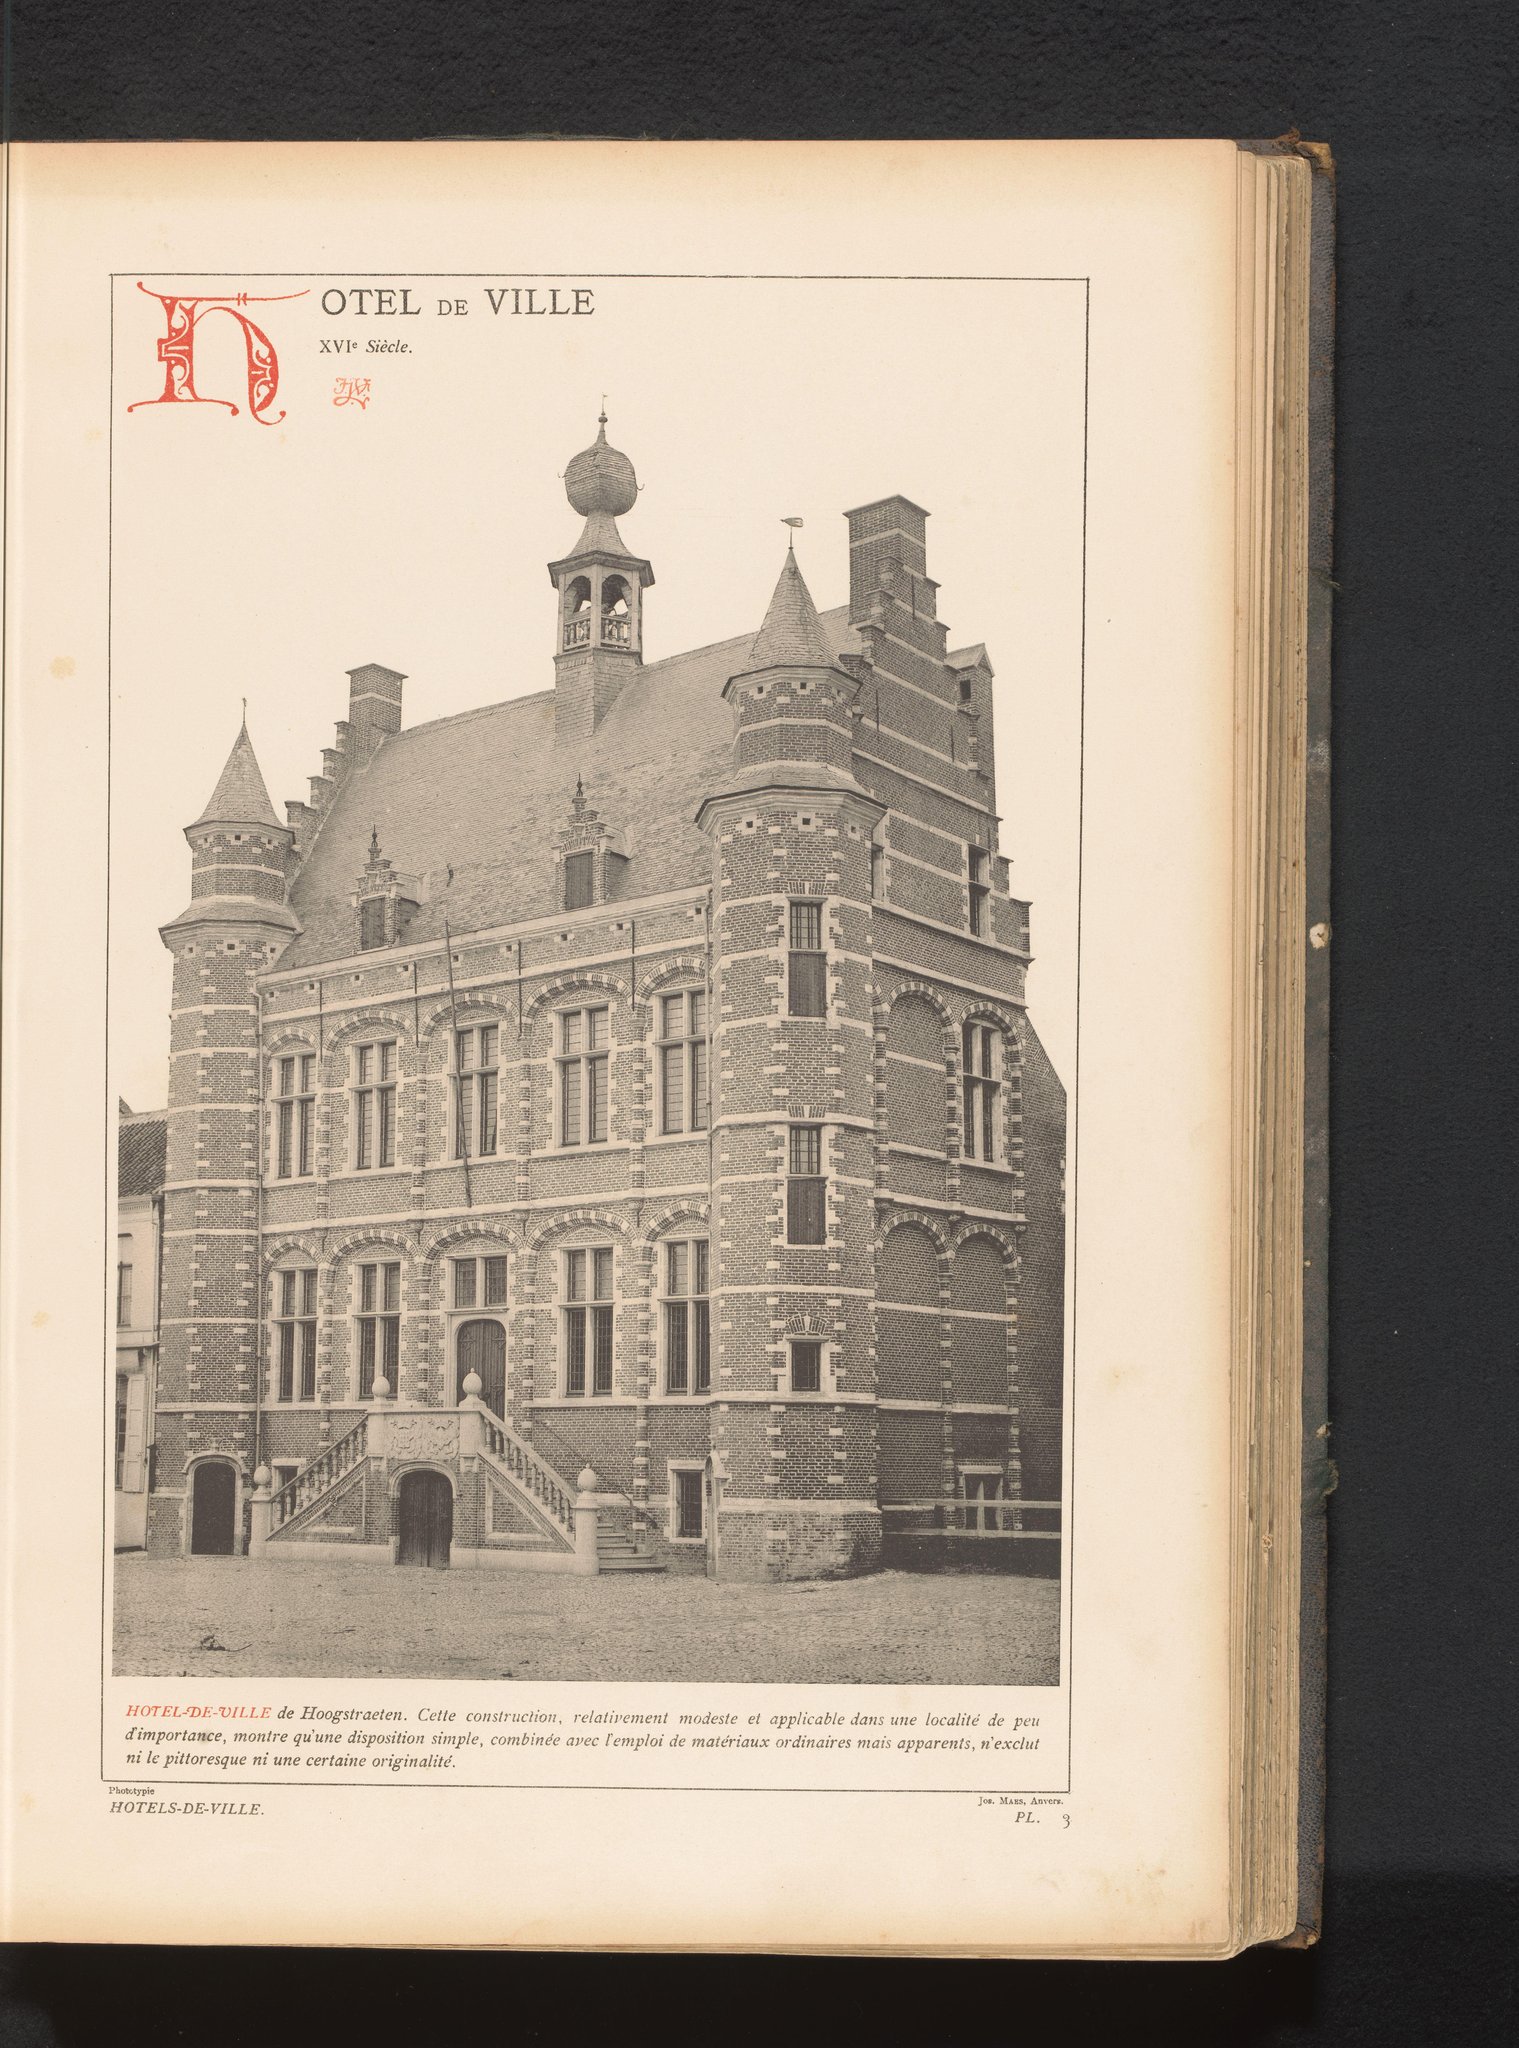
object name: page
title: Hotel de Ville, XVIe Siècle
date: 1882-1887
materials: paper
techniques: photograph, photolithography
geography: antwerp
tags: townhall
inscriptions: inscription: ‘HOTELS-DE-VILLE. - PL. 3.’, monogram: ‘JJvY’, inscription: ‘HOTEL-DE-VILLE de Hoogstraeten (...)’